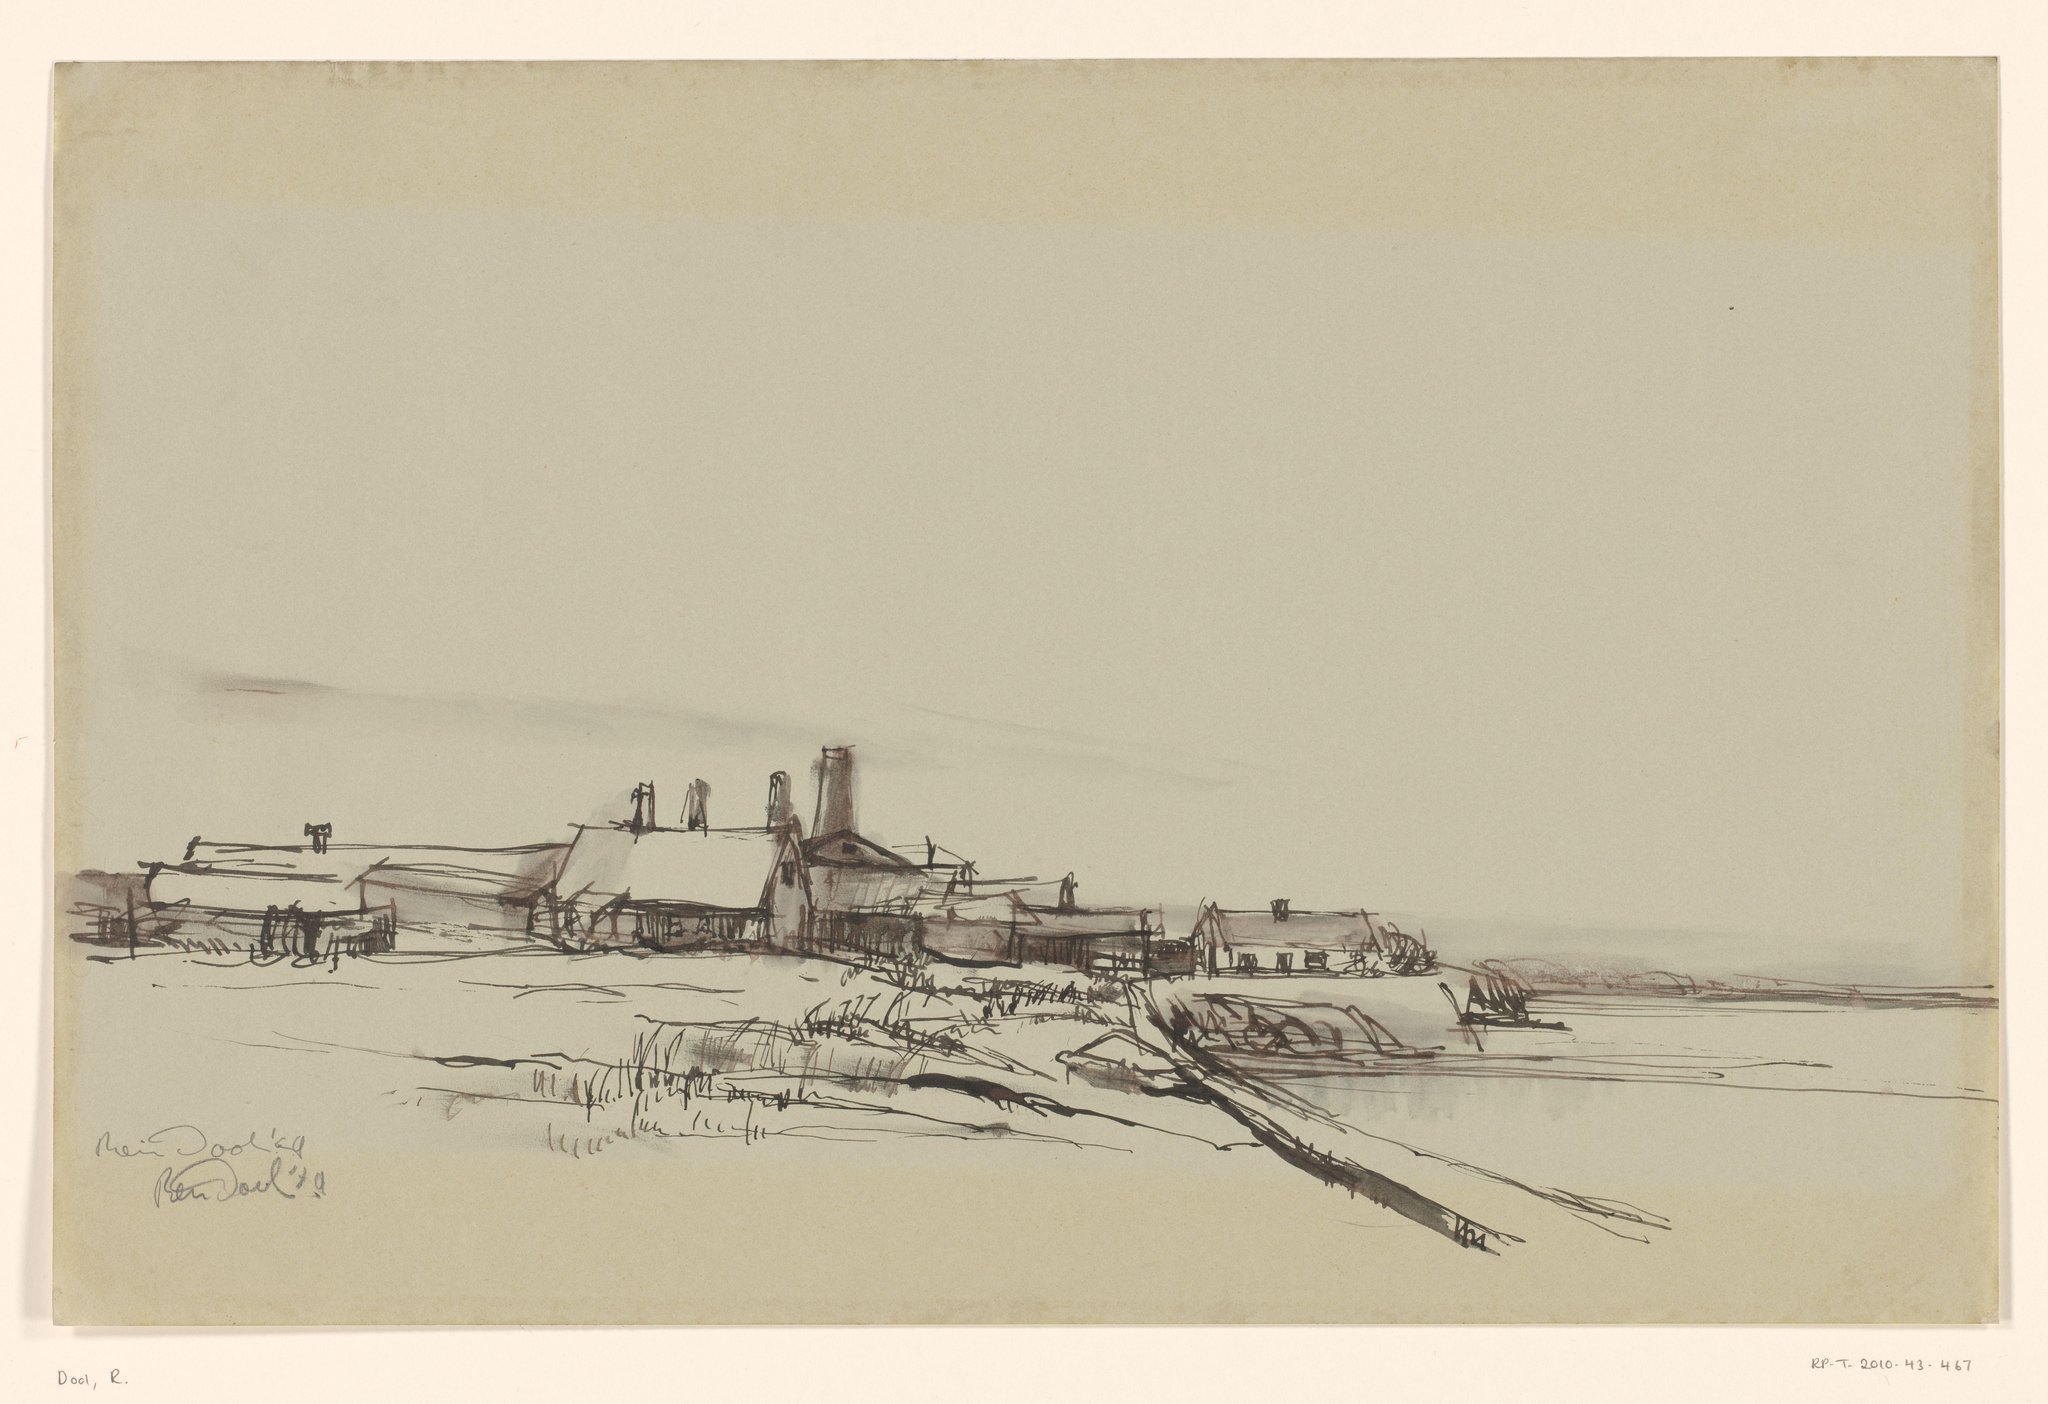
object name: drawing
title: Kust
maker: rein dool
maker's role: draughtsman, painter, print maker, sculptor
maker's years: 1933-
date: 1959-1979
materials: ink, paper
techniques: brush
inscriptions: signature and date: ‘Rein Dool '69 / Rein Dool '79’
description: Gebouwen met schoorstenen aan waterkant.